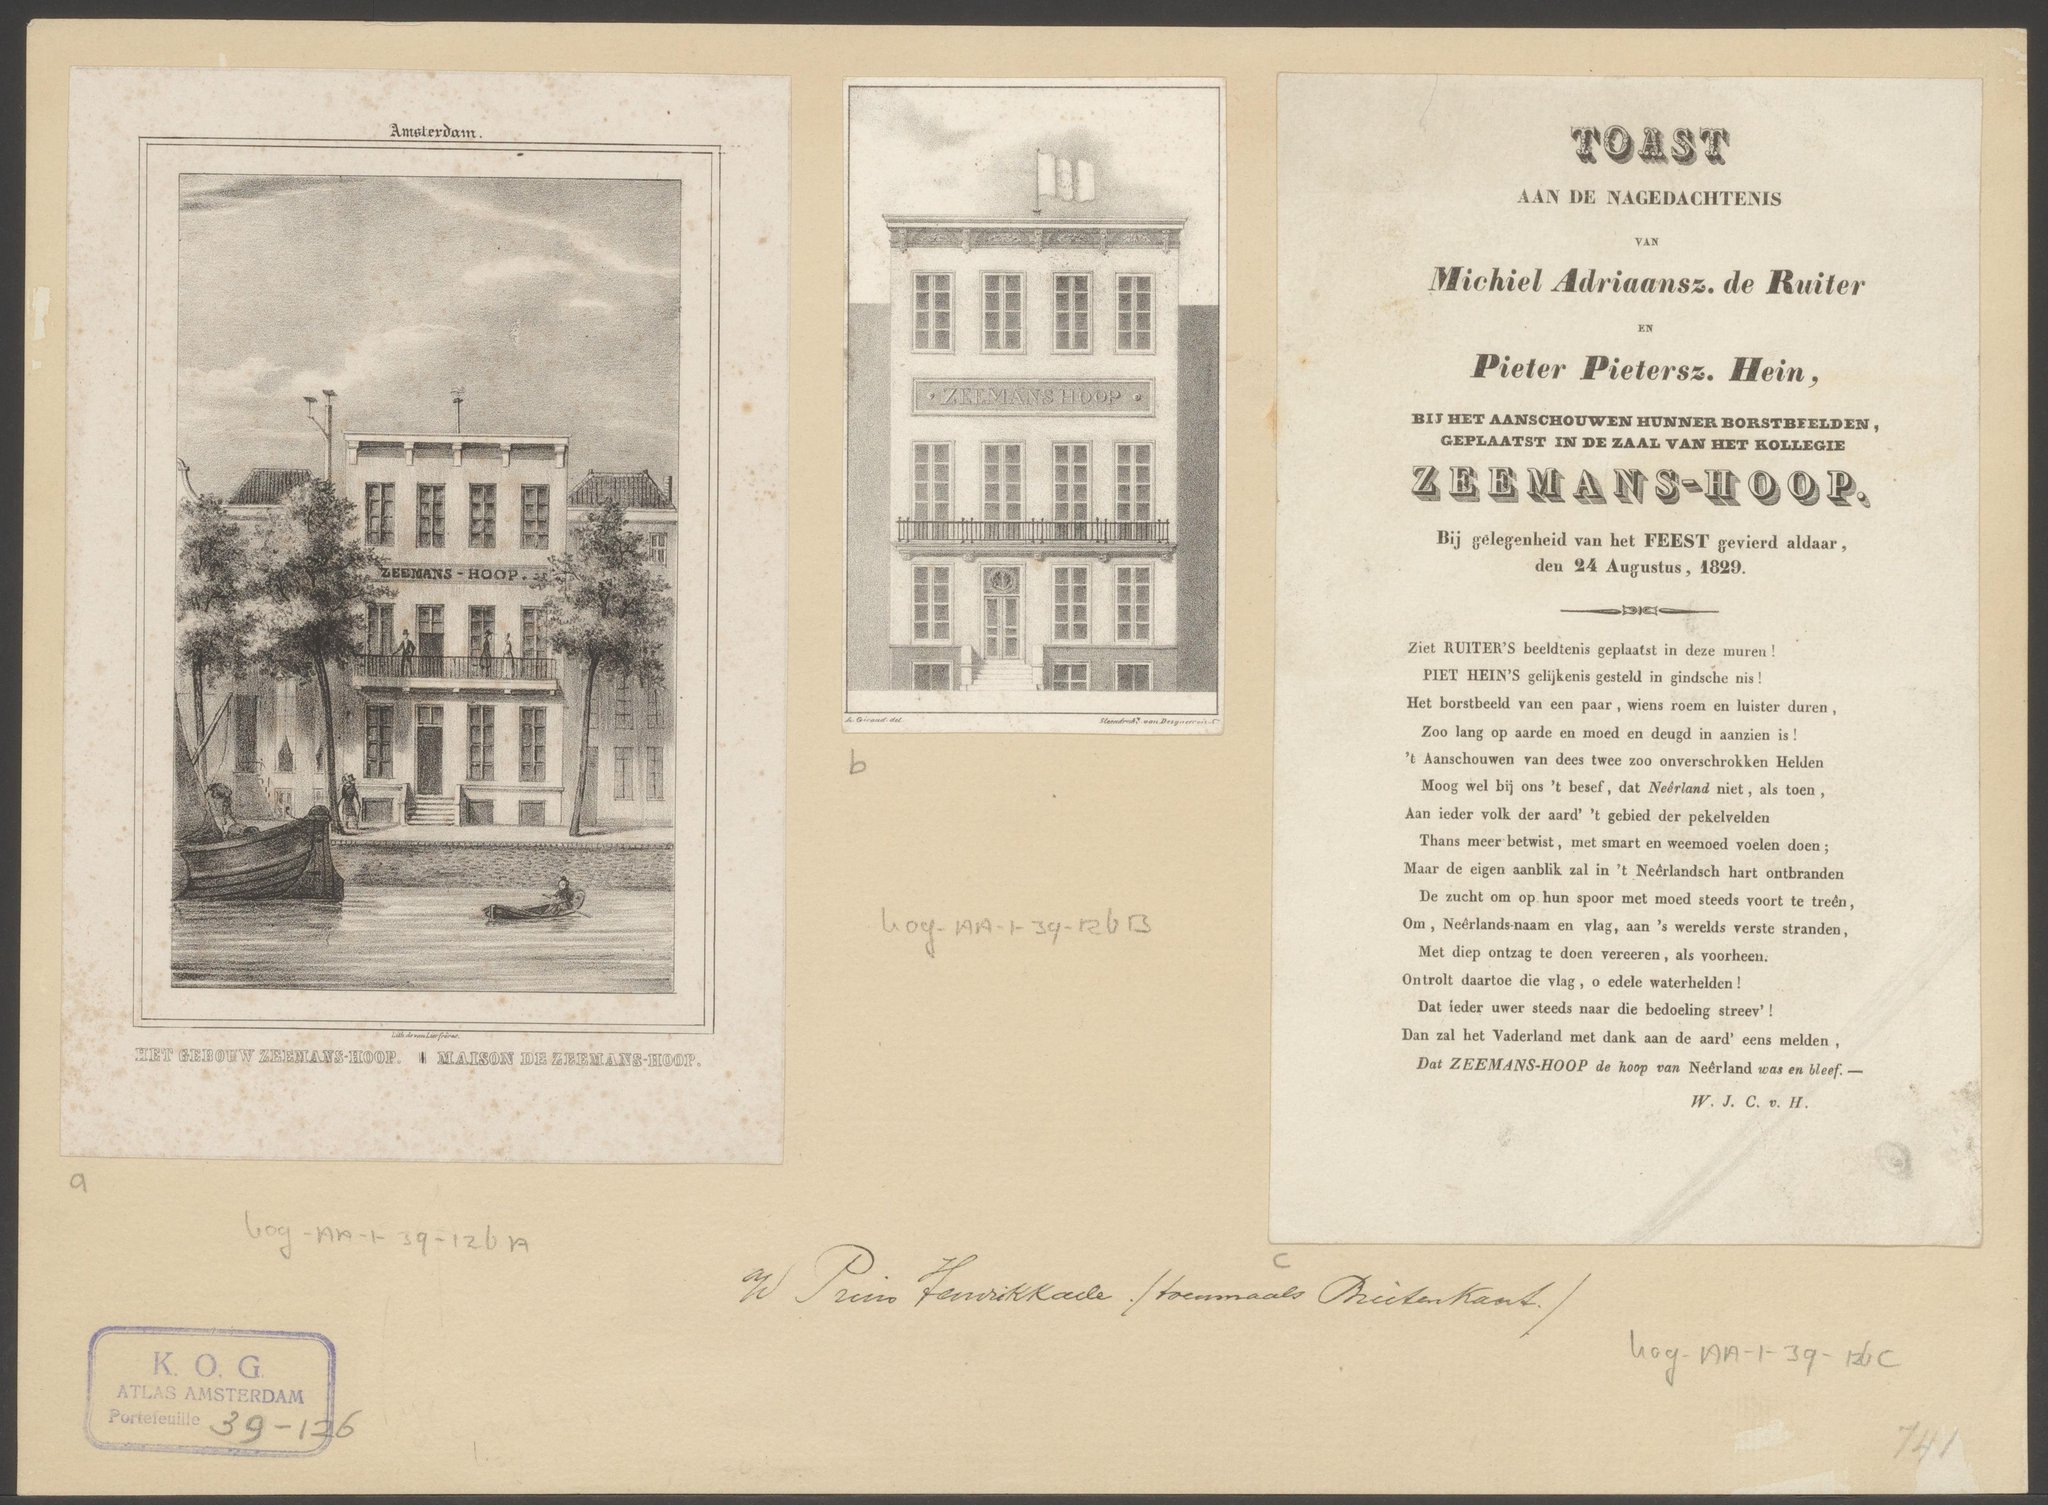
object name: print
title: Gezicht op het College Zeemanshoop aan de Prins Hendrikkade te Amsterdam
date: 1833-1846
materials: paper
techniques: lithograph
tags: civic architecture; edifices; dwellings, canals, waters (in city) (+ city(-scape) with figures, staffage)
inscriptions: collector's mark: Lugt 1641b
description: Onderwerpsrubriek binnen de Atlas Amsterdam: Armwezen en liefdadige instellingen: III. Verschillende gestichten en instellingen / Hofjes: Zeemanshoop.